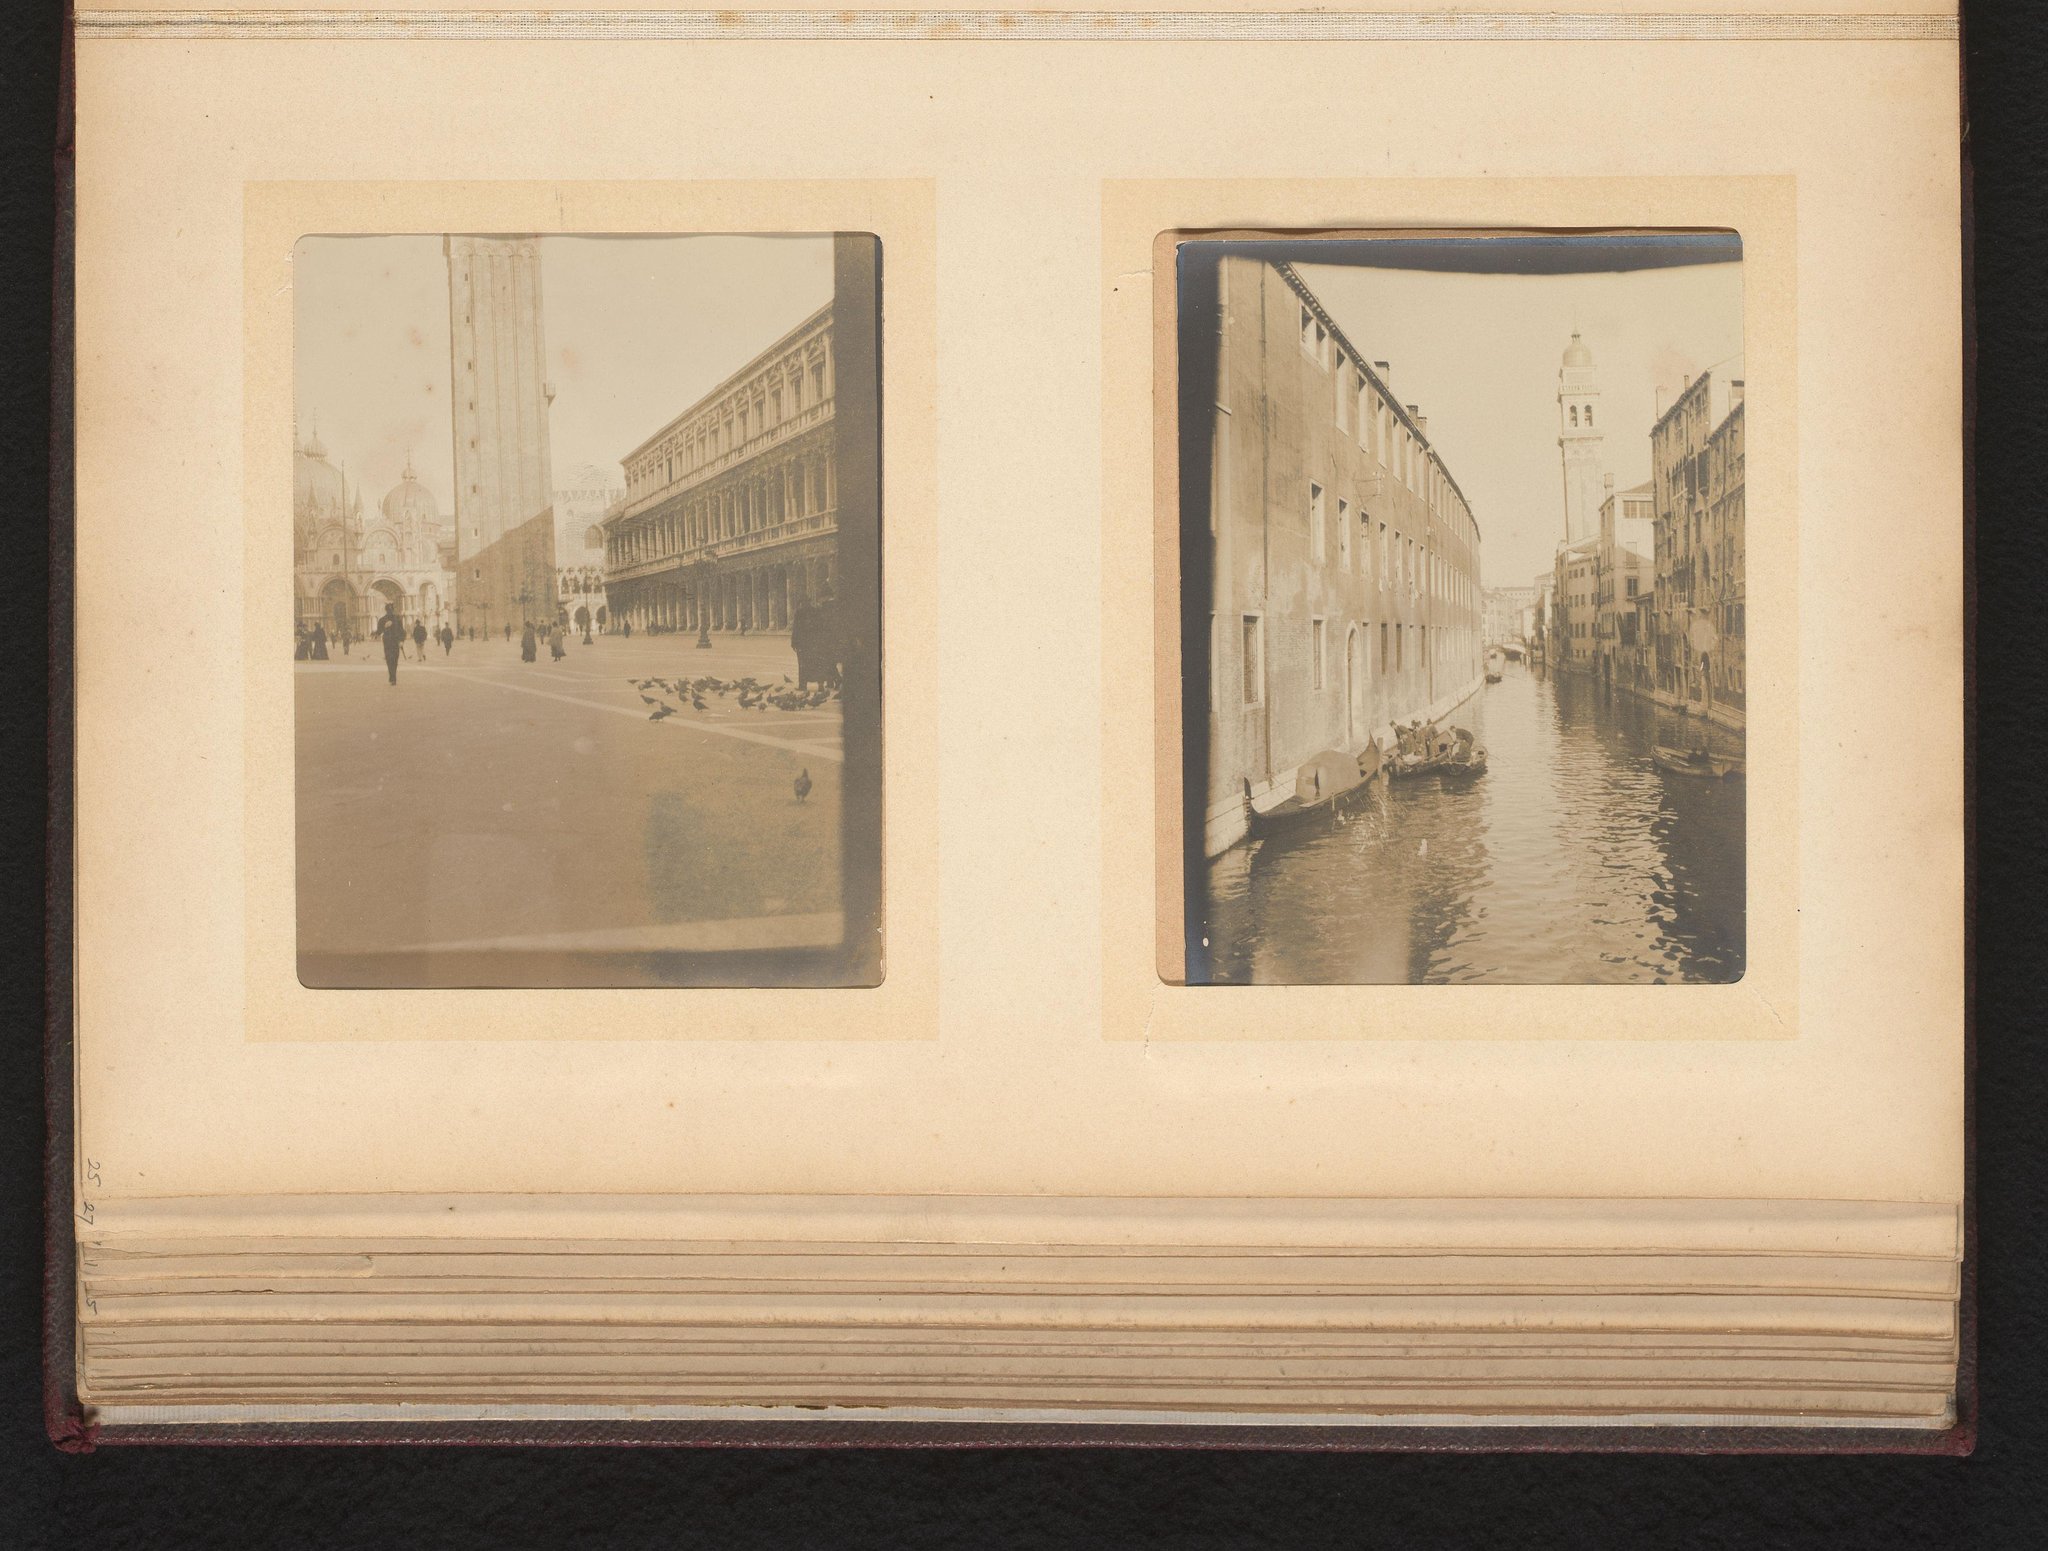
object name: photograph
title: Gezichten door een kanaal en op het San Marcoplein in Venetië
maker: Anonymous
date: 1895-1905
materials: cardboard, photographic support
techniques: gelatin silver print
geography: venice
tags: tourism, canals, waters (in city), square, place, circus, etc. (+ city(-scape) with figures, staffage), venice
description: Albumblad met twee foto's in Venetië. Onderdeel van een fotoalbum van een reis door Italië, ca. 1900.